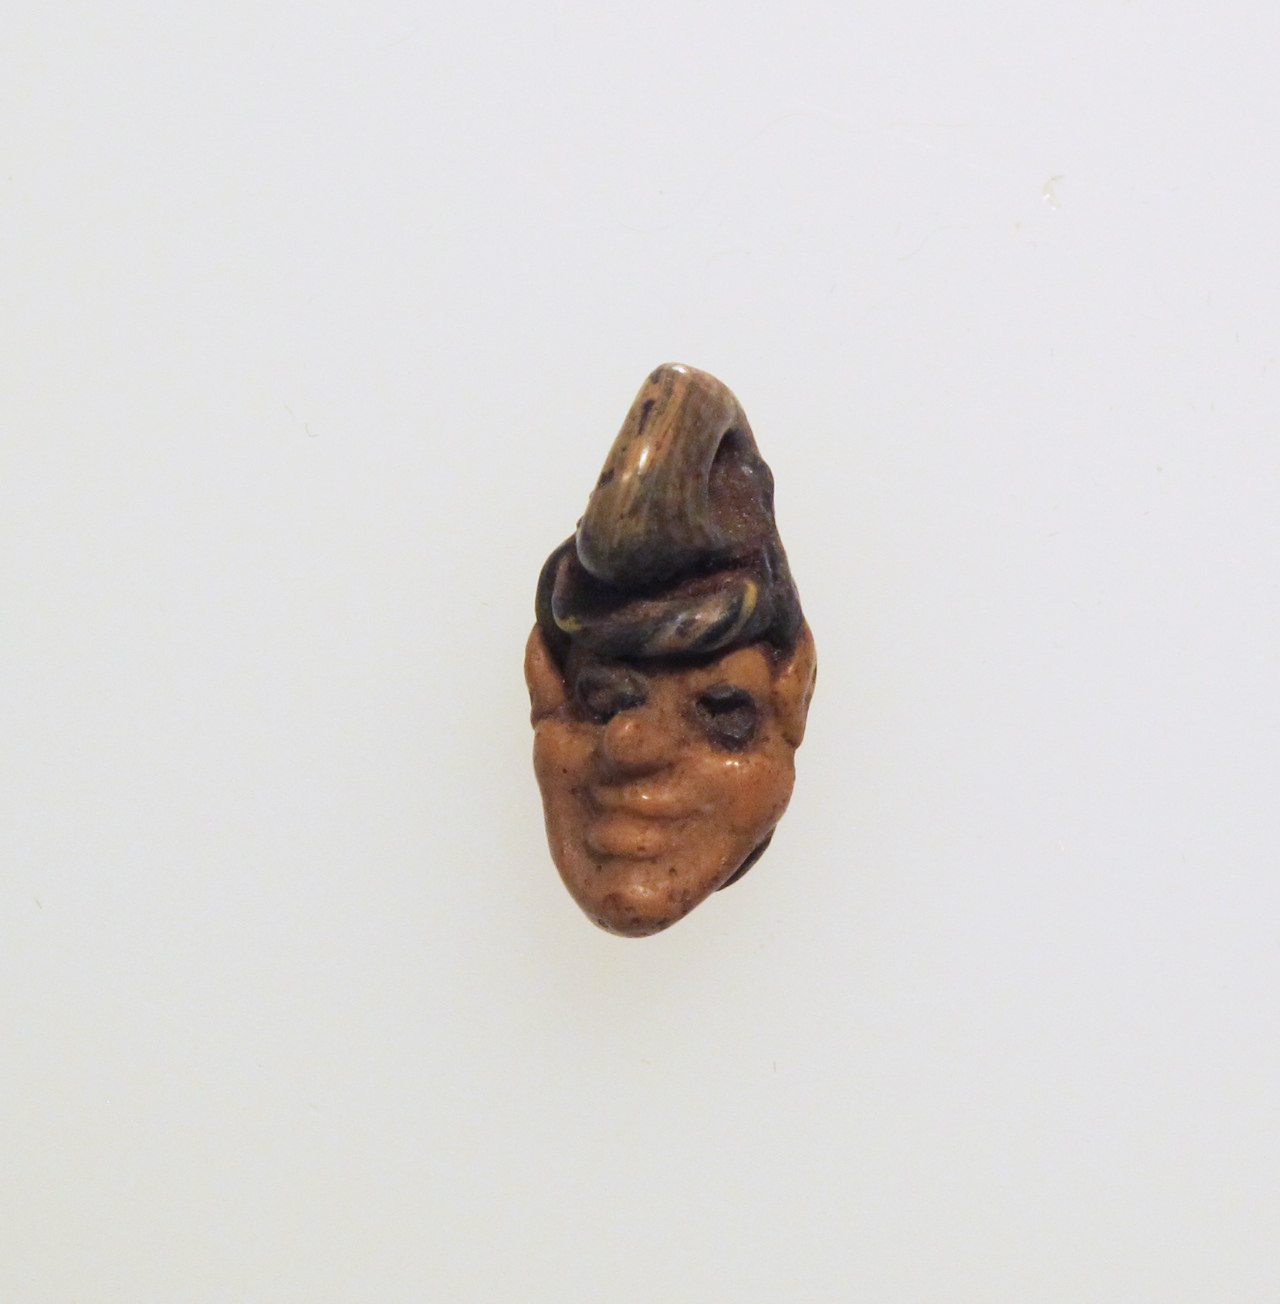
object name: head pendant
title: Glass head pendant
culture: carthaginian or eastern mediterranean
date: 300-1 BCE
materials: glass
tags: heads,men